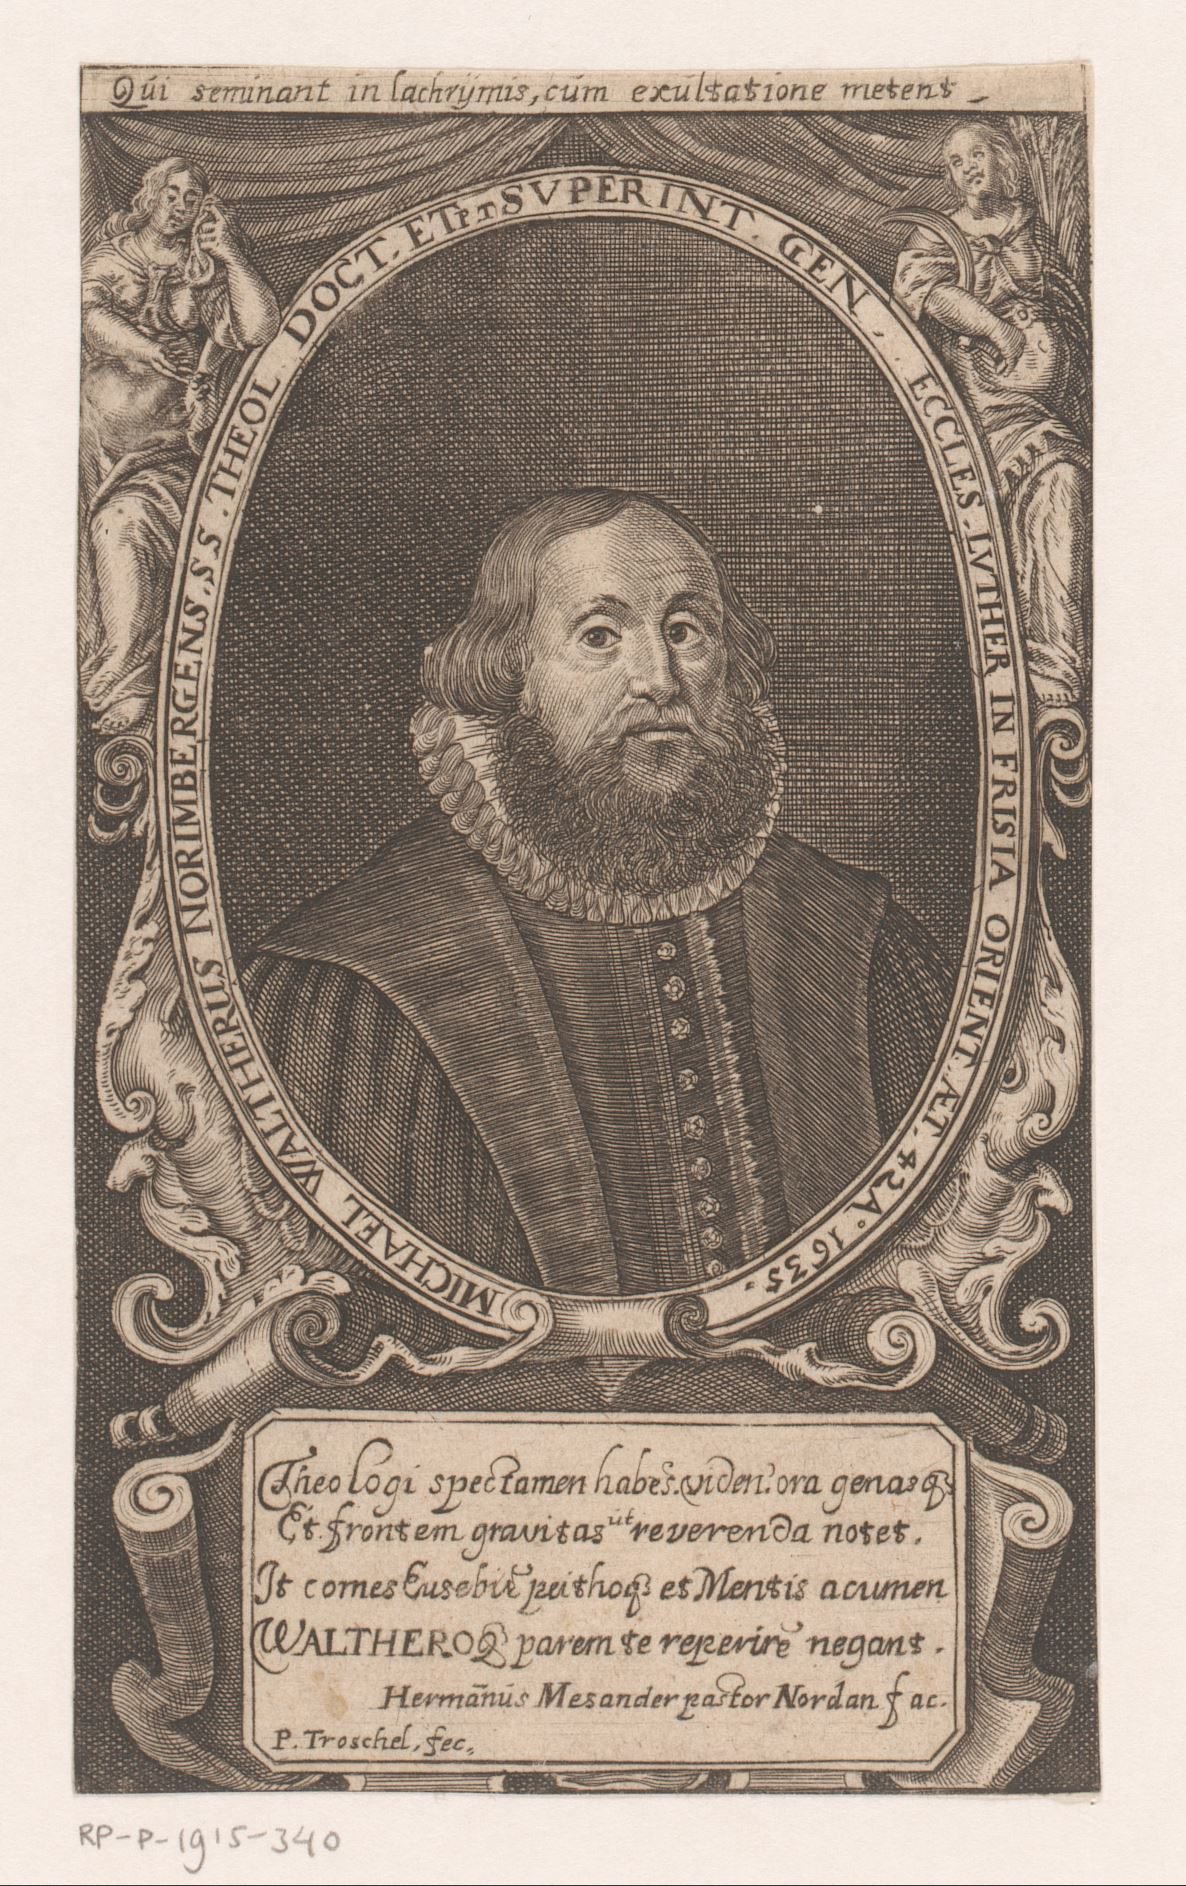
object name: print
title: Portret van Michael Walther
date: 1640-1670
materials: paper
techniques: engraving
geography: germany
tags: historical persons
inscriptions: collector's mark: Lugt 2228